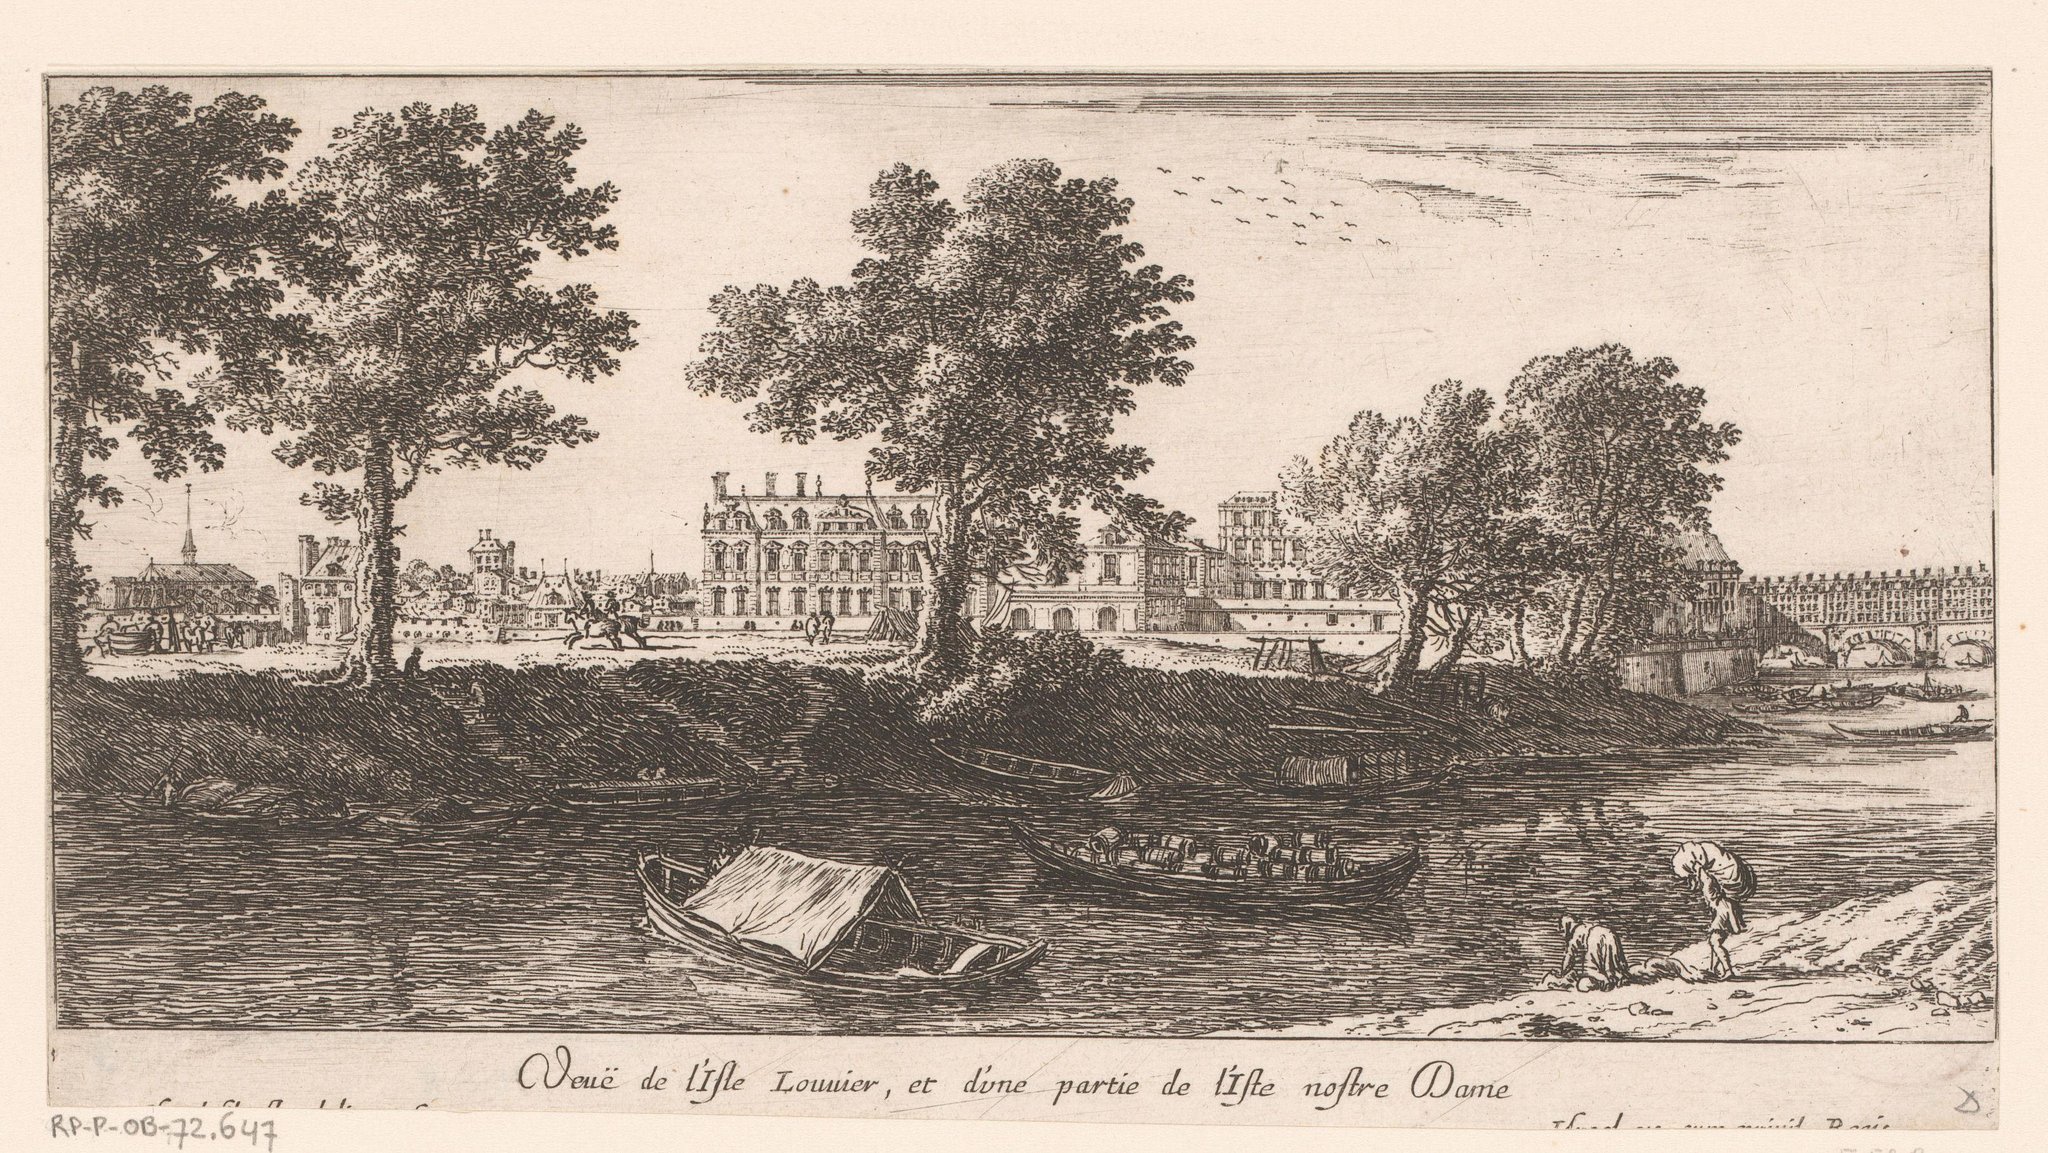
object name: print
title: Veue de l'Isle Louvier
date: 1650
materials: paper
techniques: etching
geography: france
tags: water course, paris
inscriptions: collector's mark: Lugt 240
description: Prent maakt deel uit van een ongenummerde serie van zestien prenten.